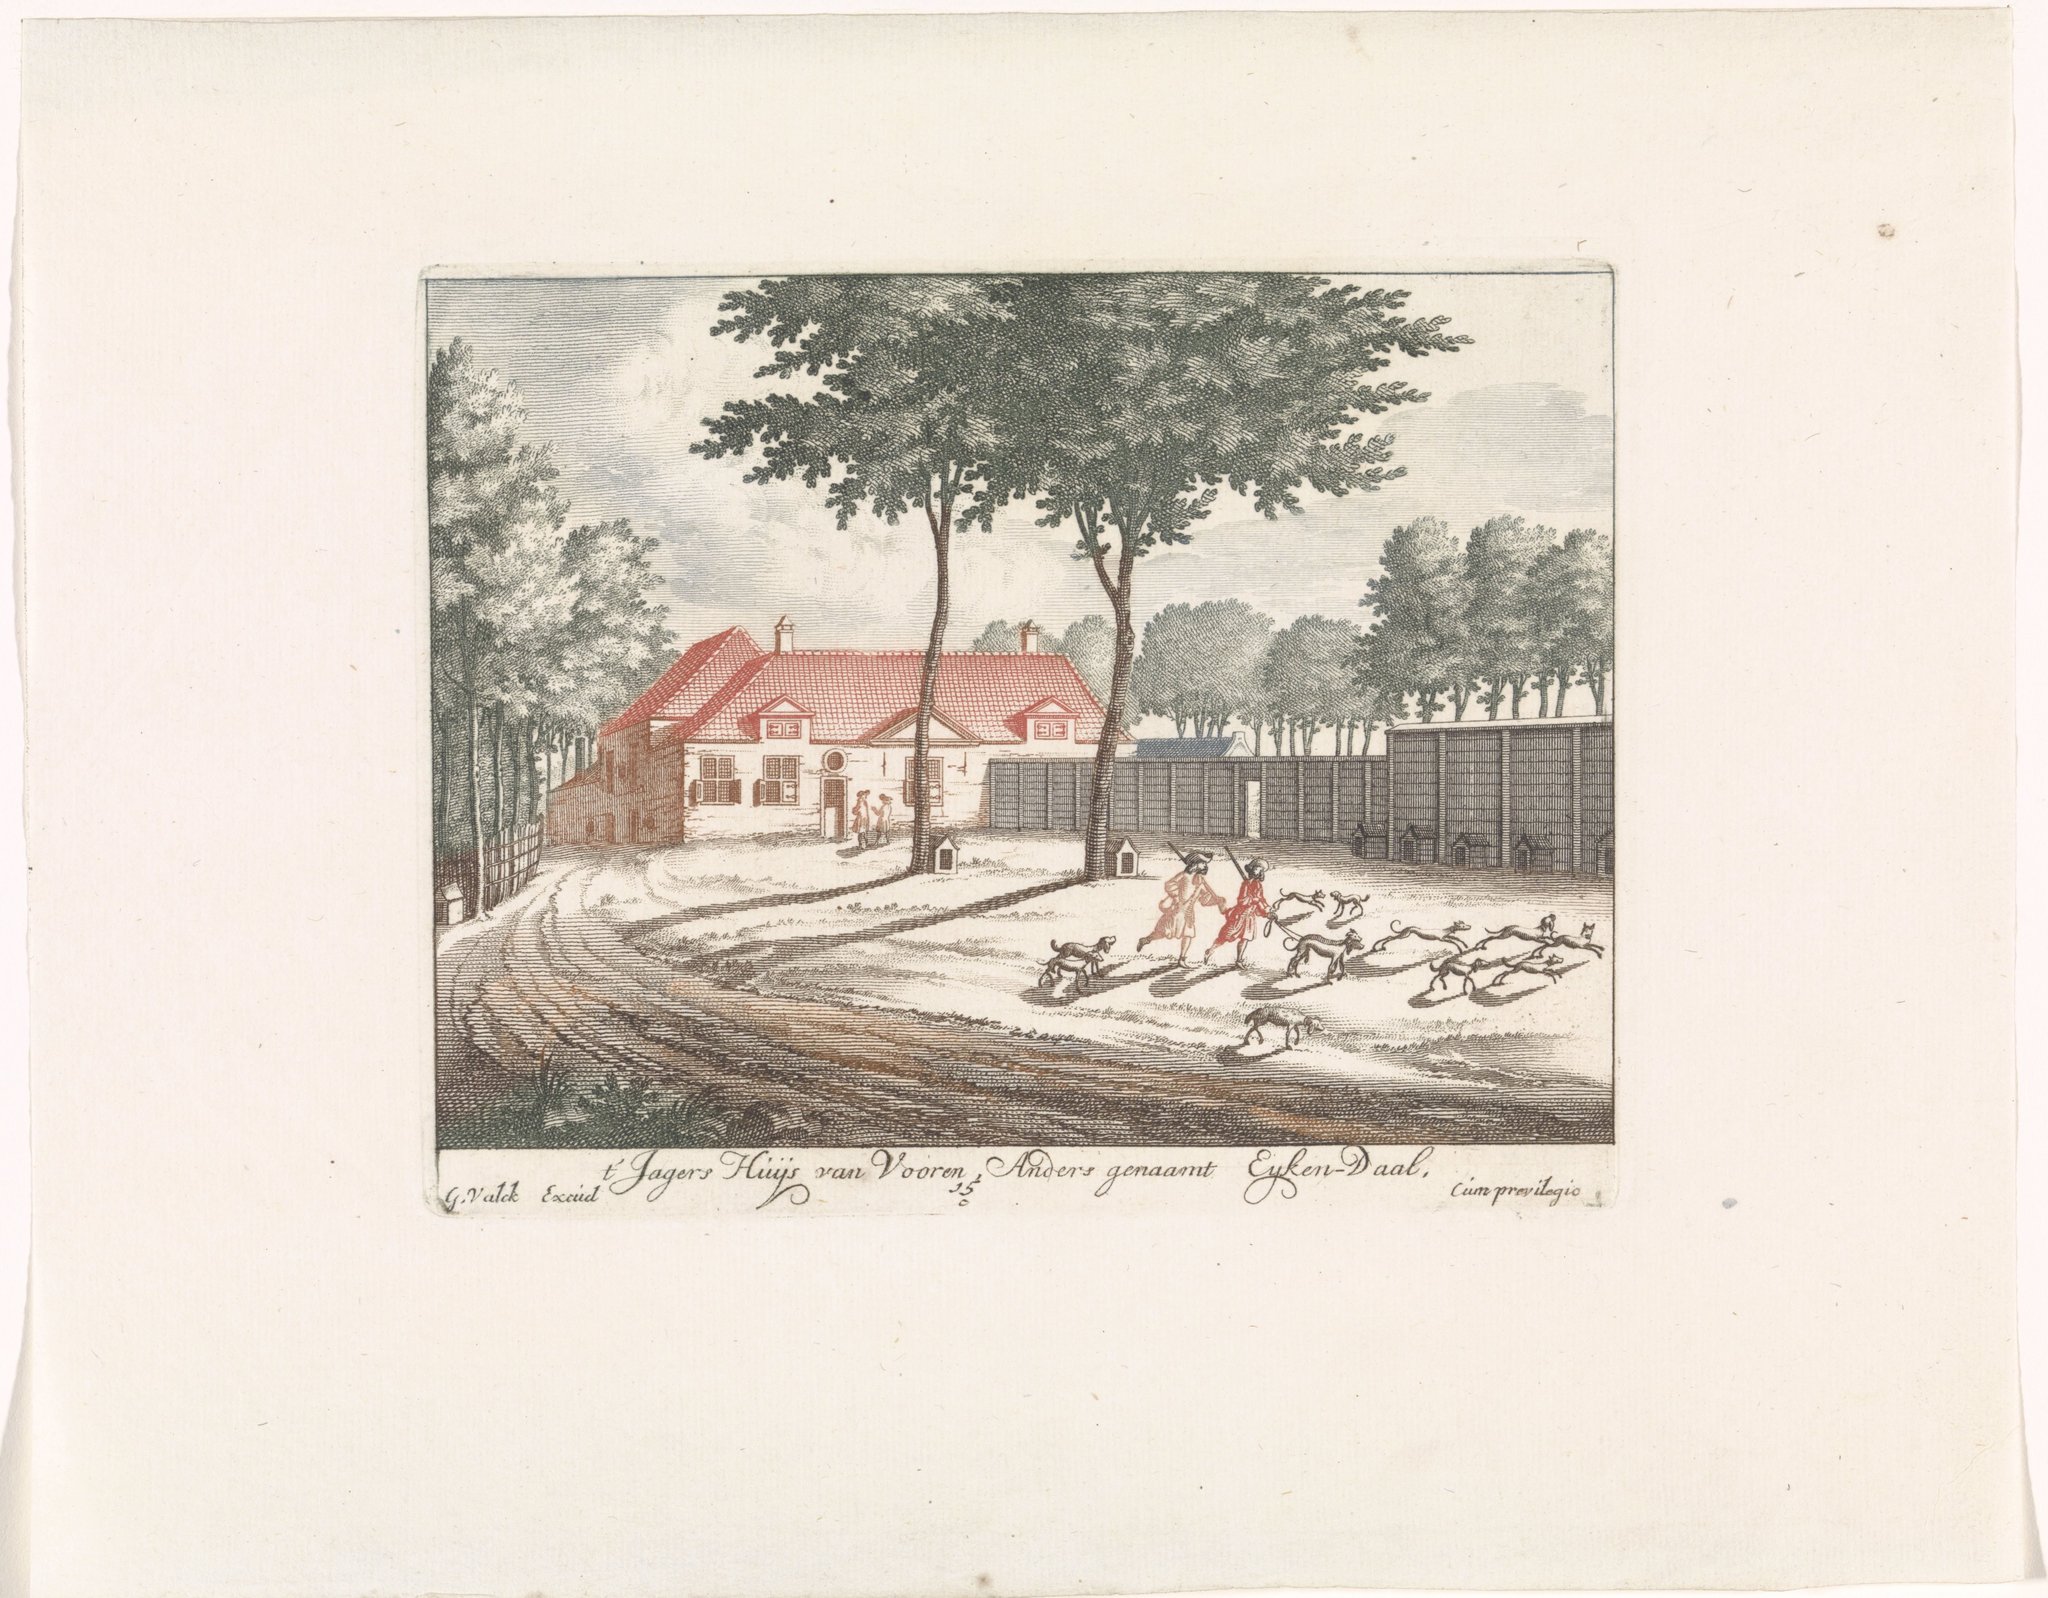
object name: print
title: t jagers Huijs van Vooren, Anders genaamt Eyken-Daal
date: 1695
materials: paper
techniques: etching, lithography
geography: amsterdam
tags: the hague, william iii (prince of orange and king of england, scotland, and ireland), hunter, farm or solitary house in landscape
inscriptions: collector's mark: Lugt 2760, collector's mark: Lugt 2228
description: Het onderkomen van de jagers bij Paleis Soestdijk, het jachtslot van stadhouder Willem III van Oranje-Nassau. Op de voorgrond jagers met de jachthonden. Langs de muur verschillende hondenhokken.